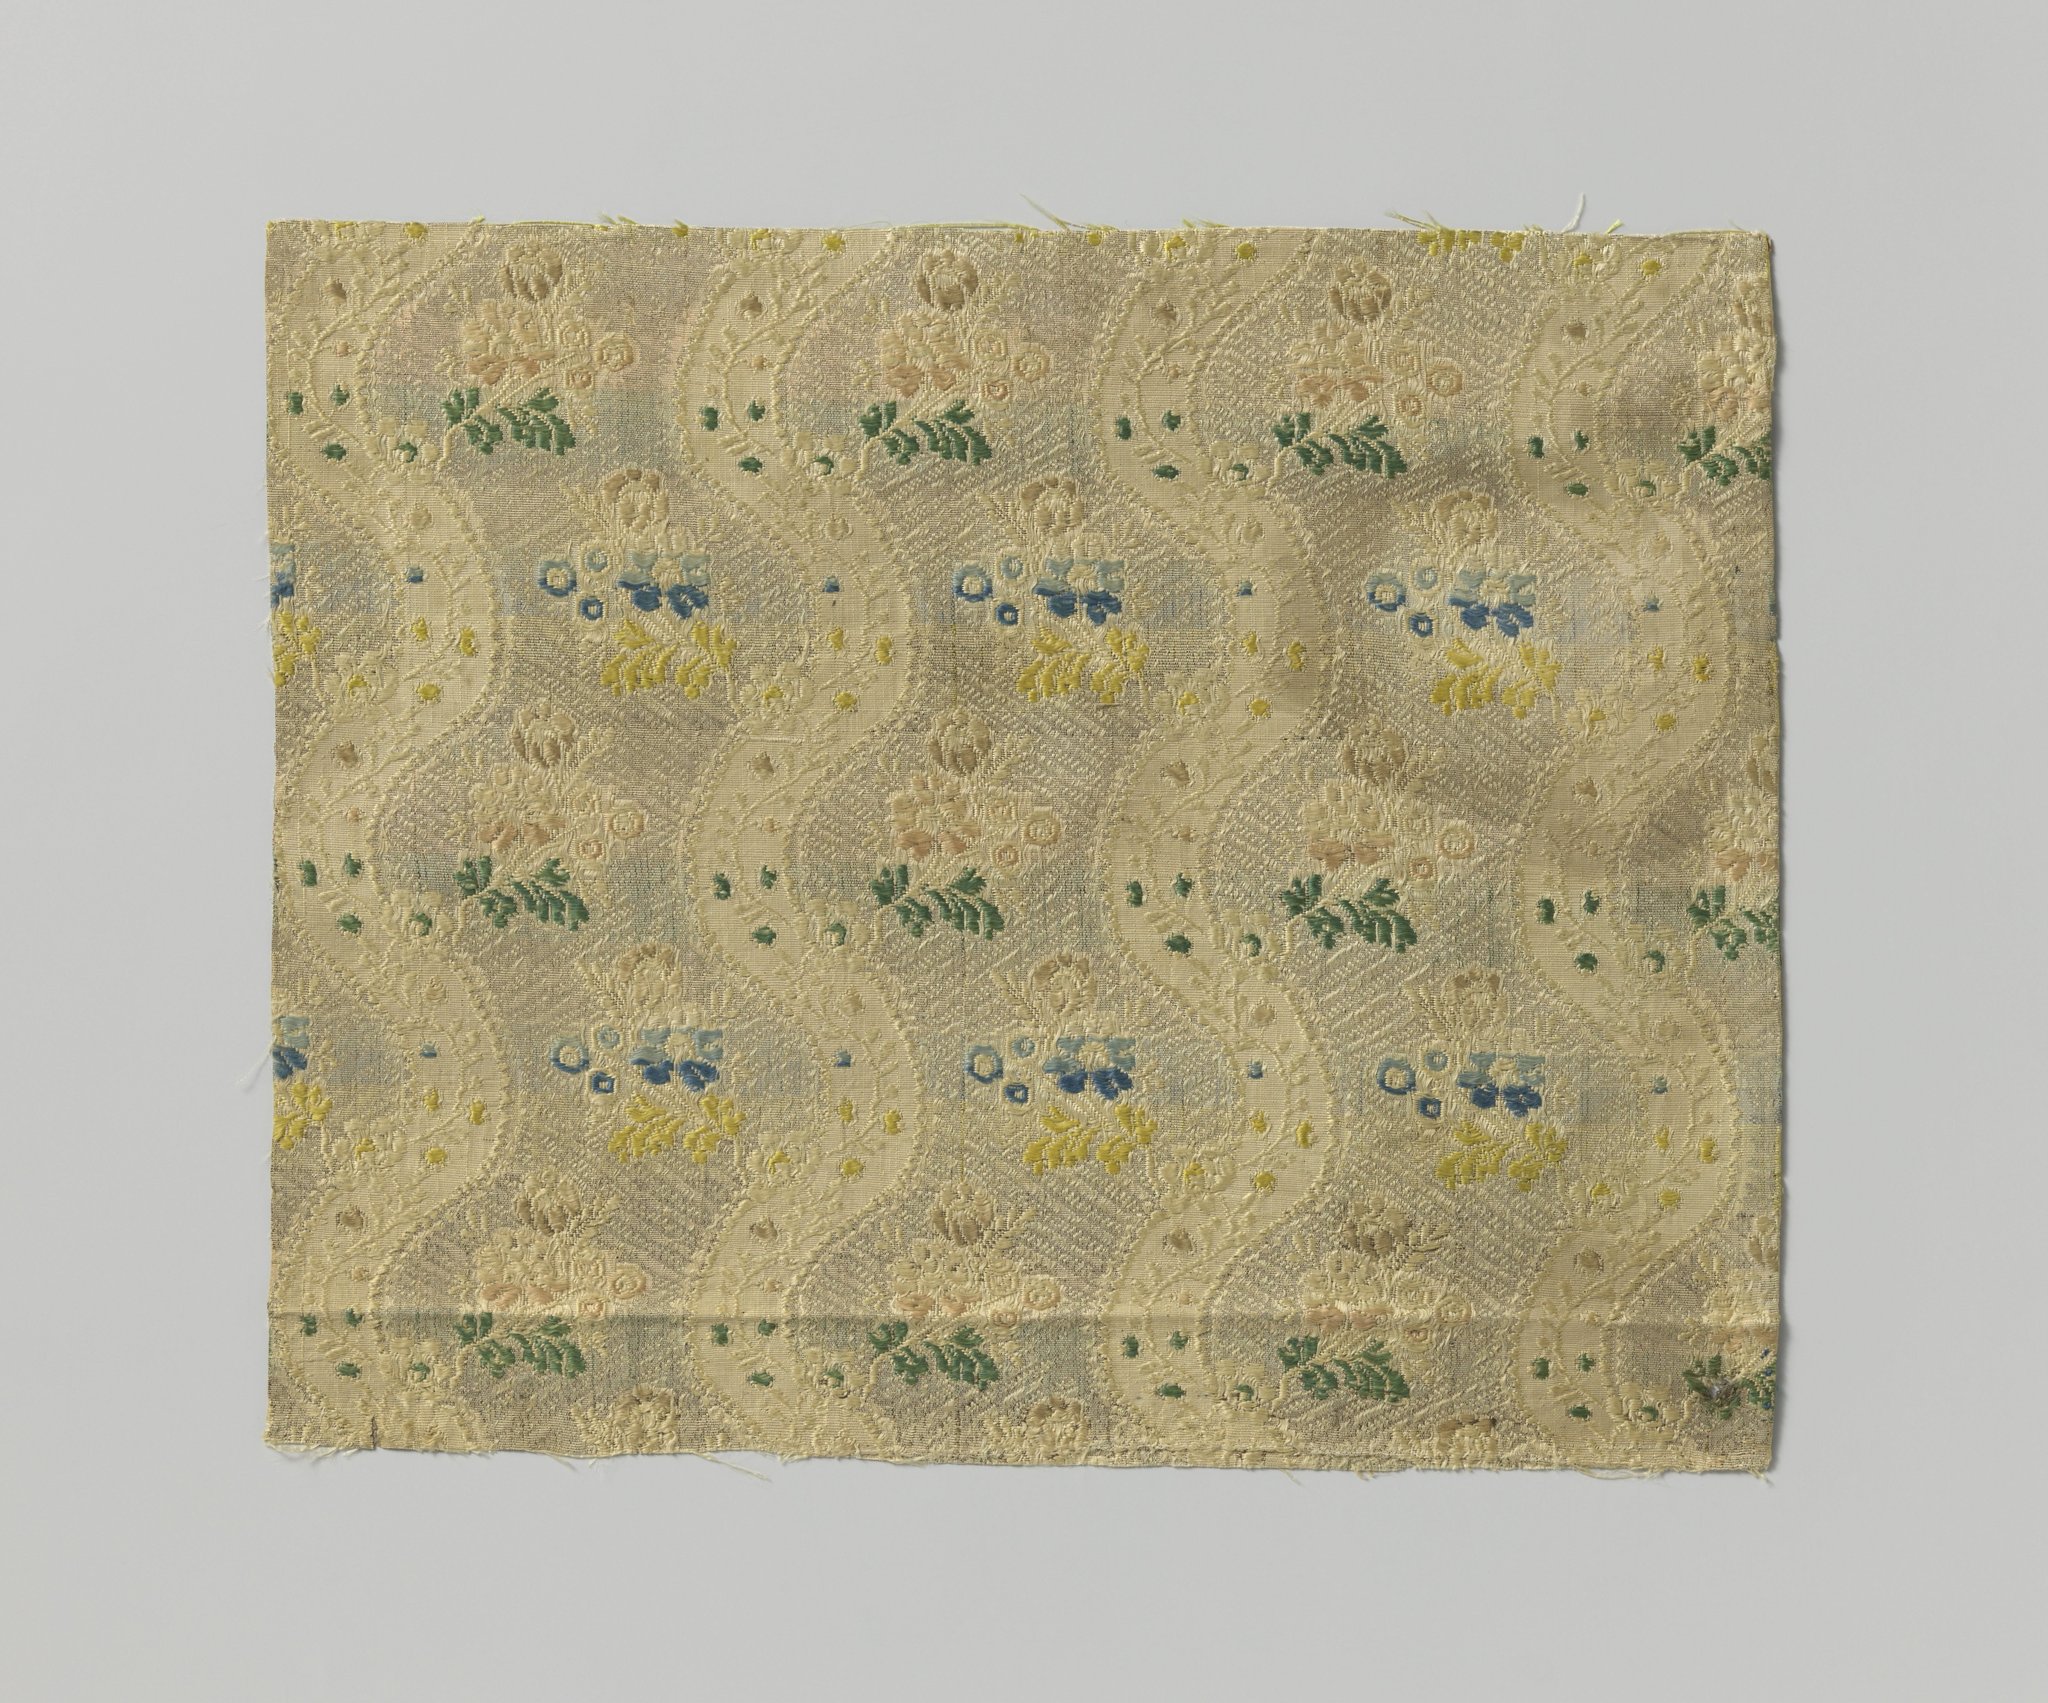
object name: zijdelampas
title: Fragment veelkleurig zijdelampas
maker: Anonymous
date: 1750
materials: silk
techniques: lampas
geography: netherlands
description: Een fragment zijdeweefsel met een grond waarop slingerende banen waarbinnen fijne bloemranken. Tussen de slingerende banen is de grond gestreept waarop veelkleurige bloemtakken.